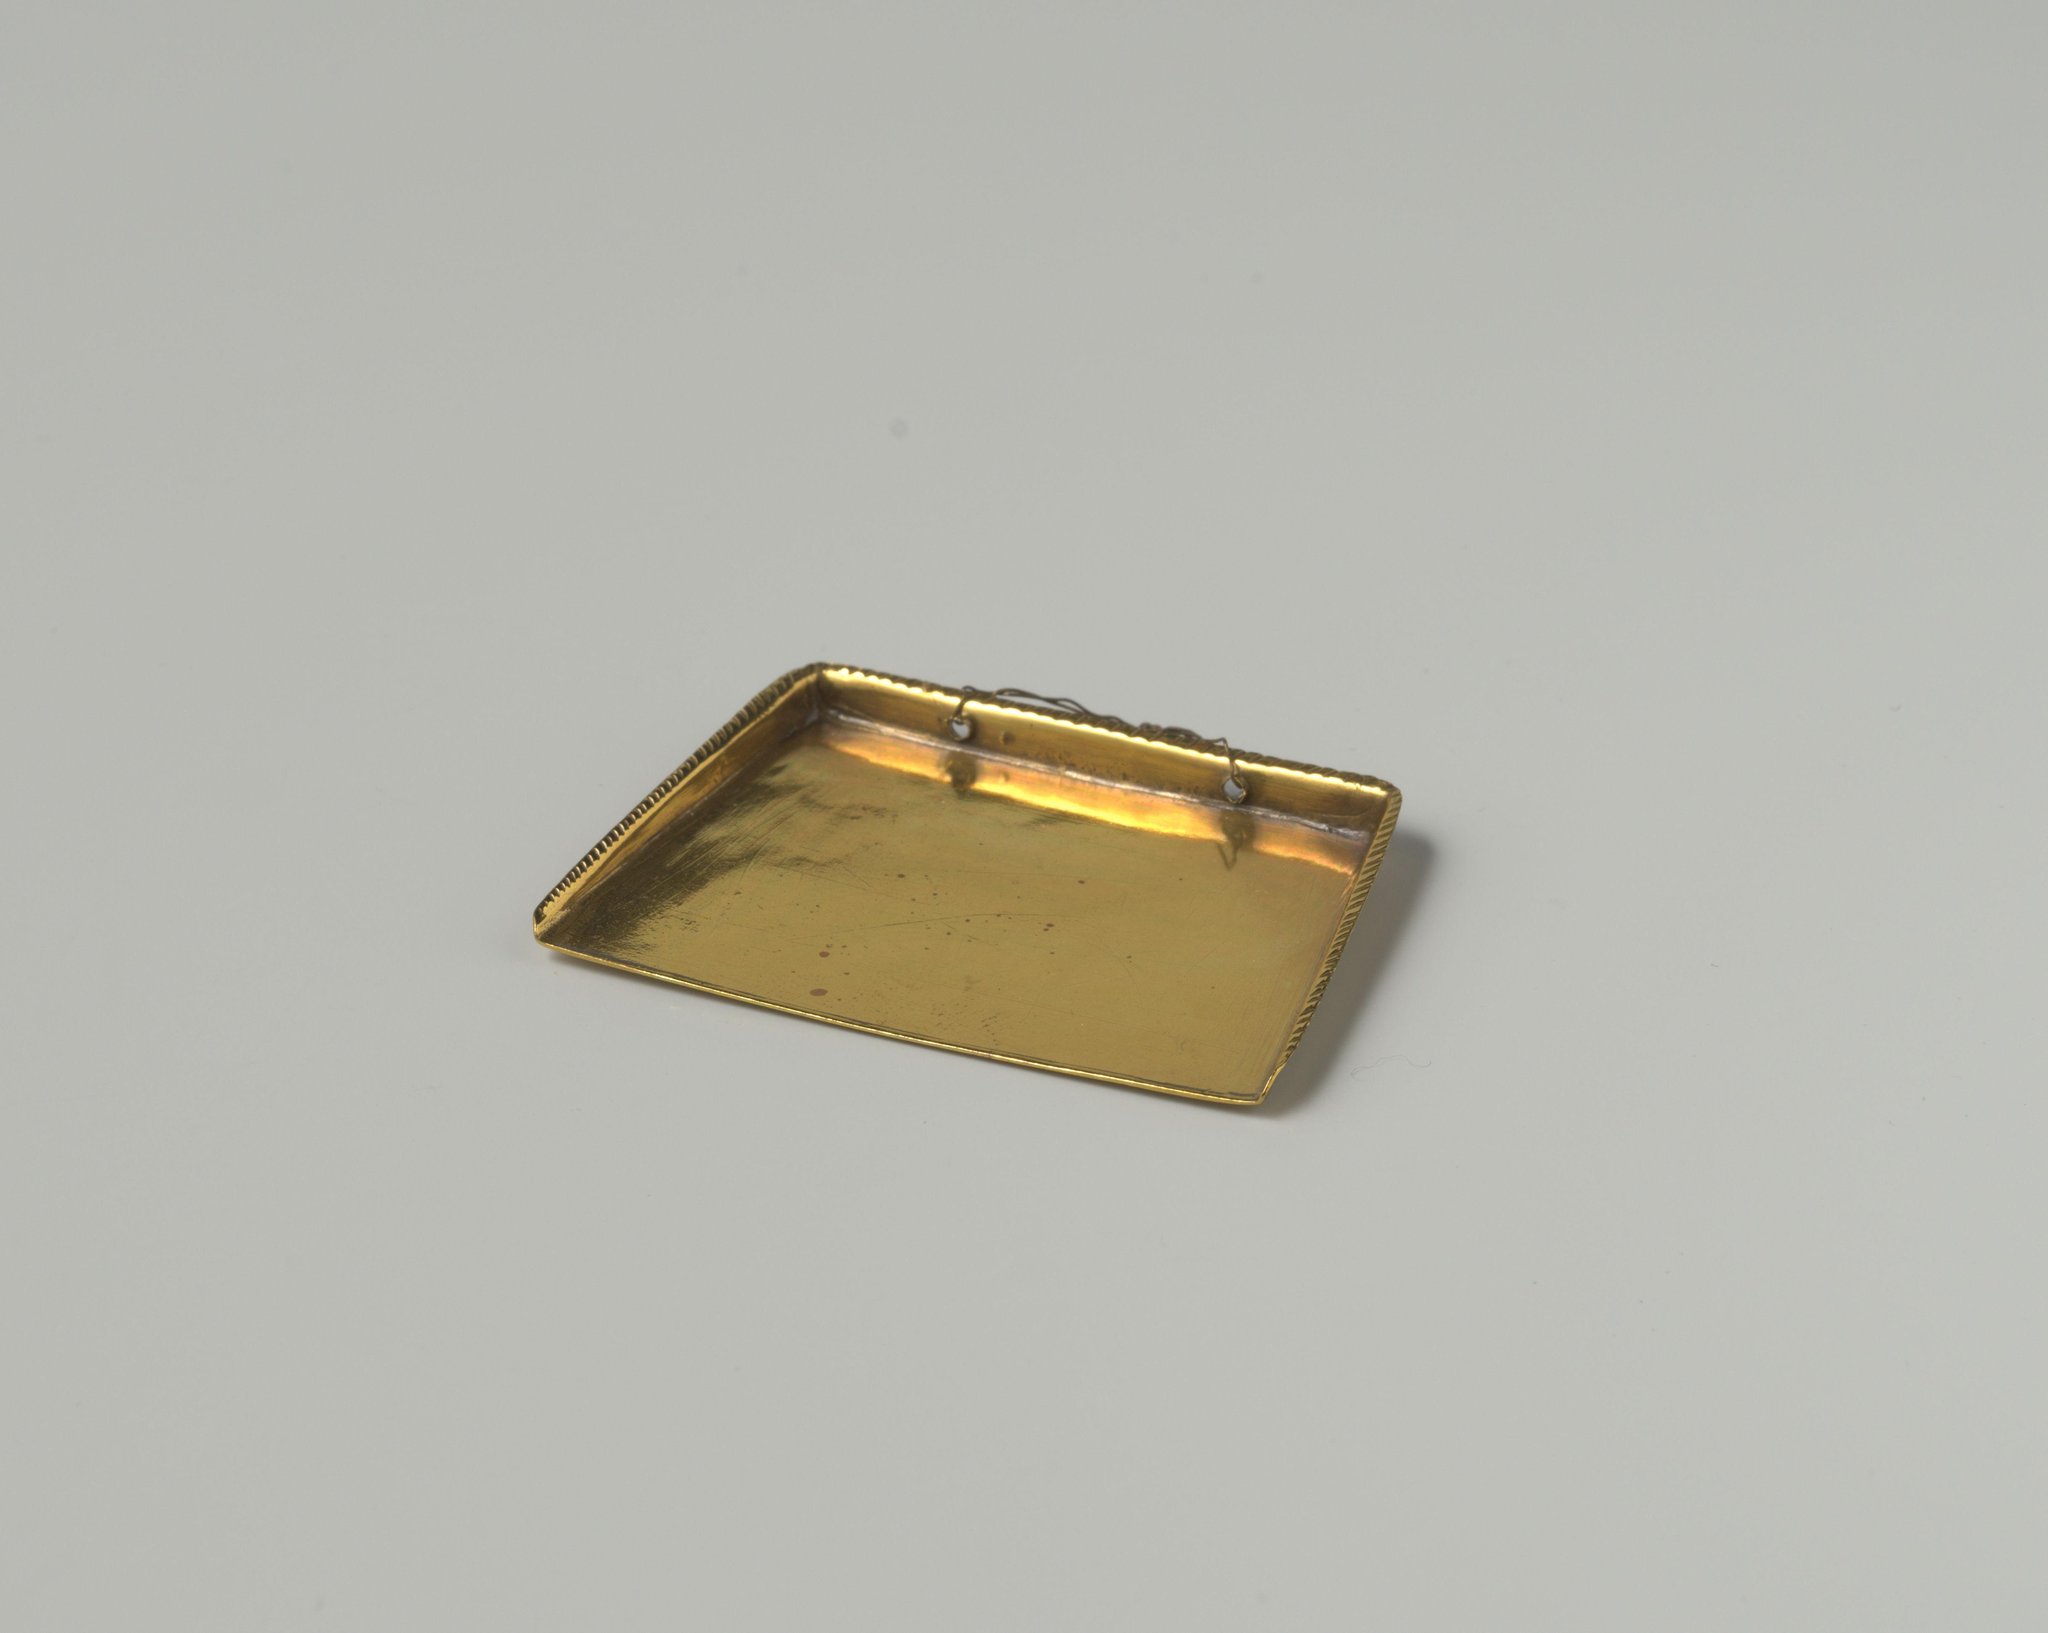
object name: dustpan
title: Stofblik van geel koper, opstaande randen versierd met groefjes; handvat afgebroken en vervangen door dun koperen draadje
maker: Anonymous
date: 1690-1710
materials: copper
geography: amsterdam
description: Stofblik van geelkoper, opstaande randen versierd met groefjes; handvat afgebroken en vervangen door dun koperen draadje.